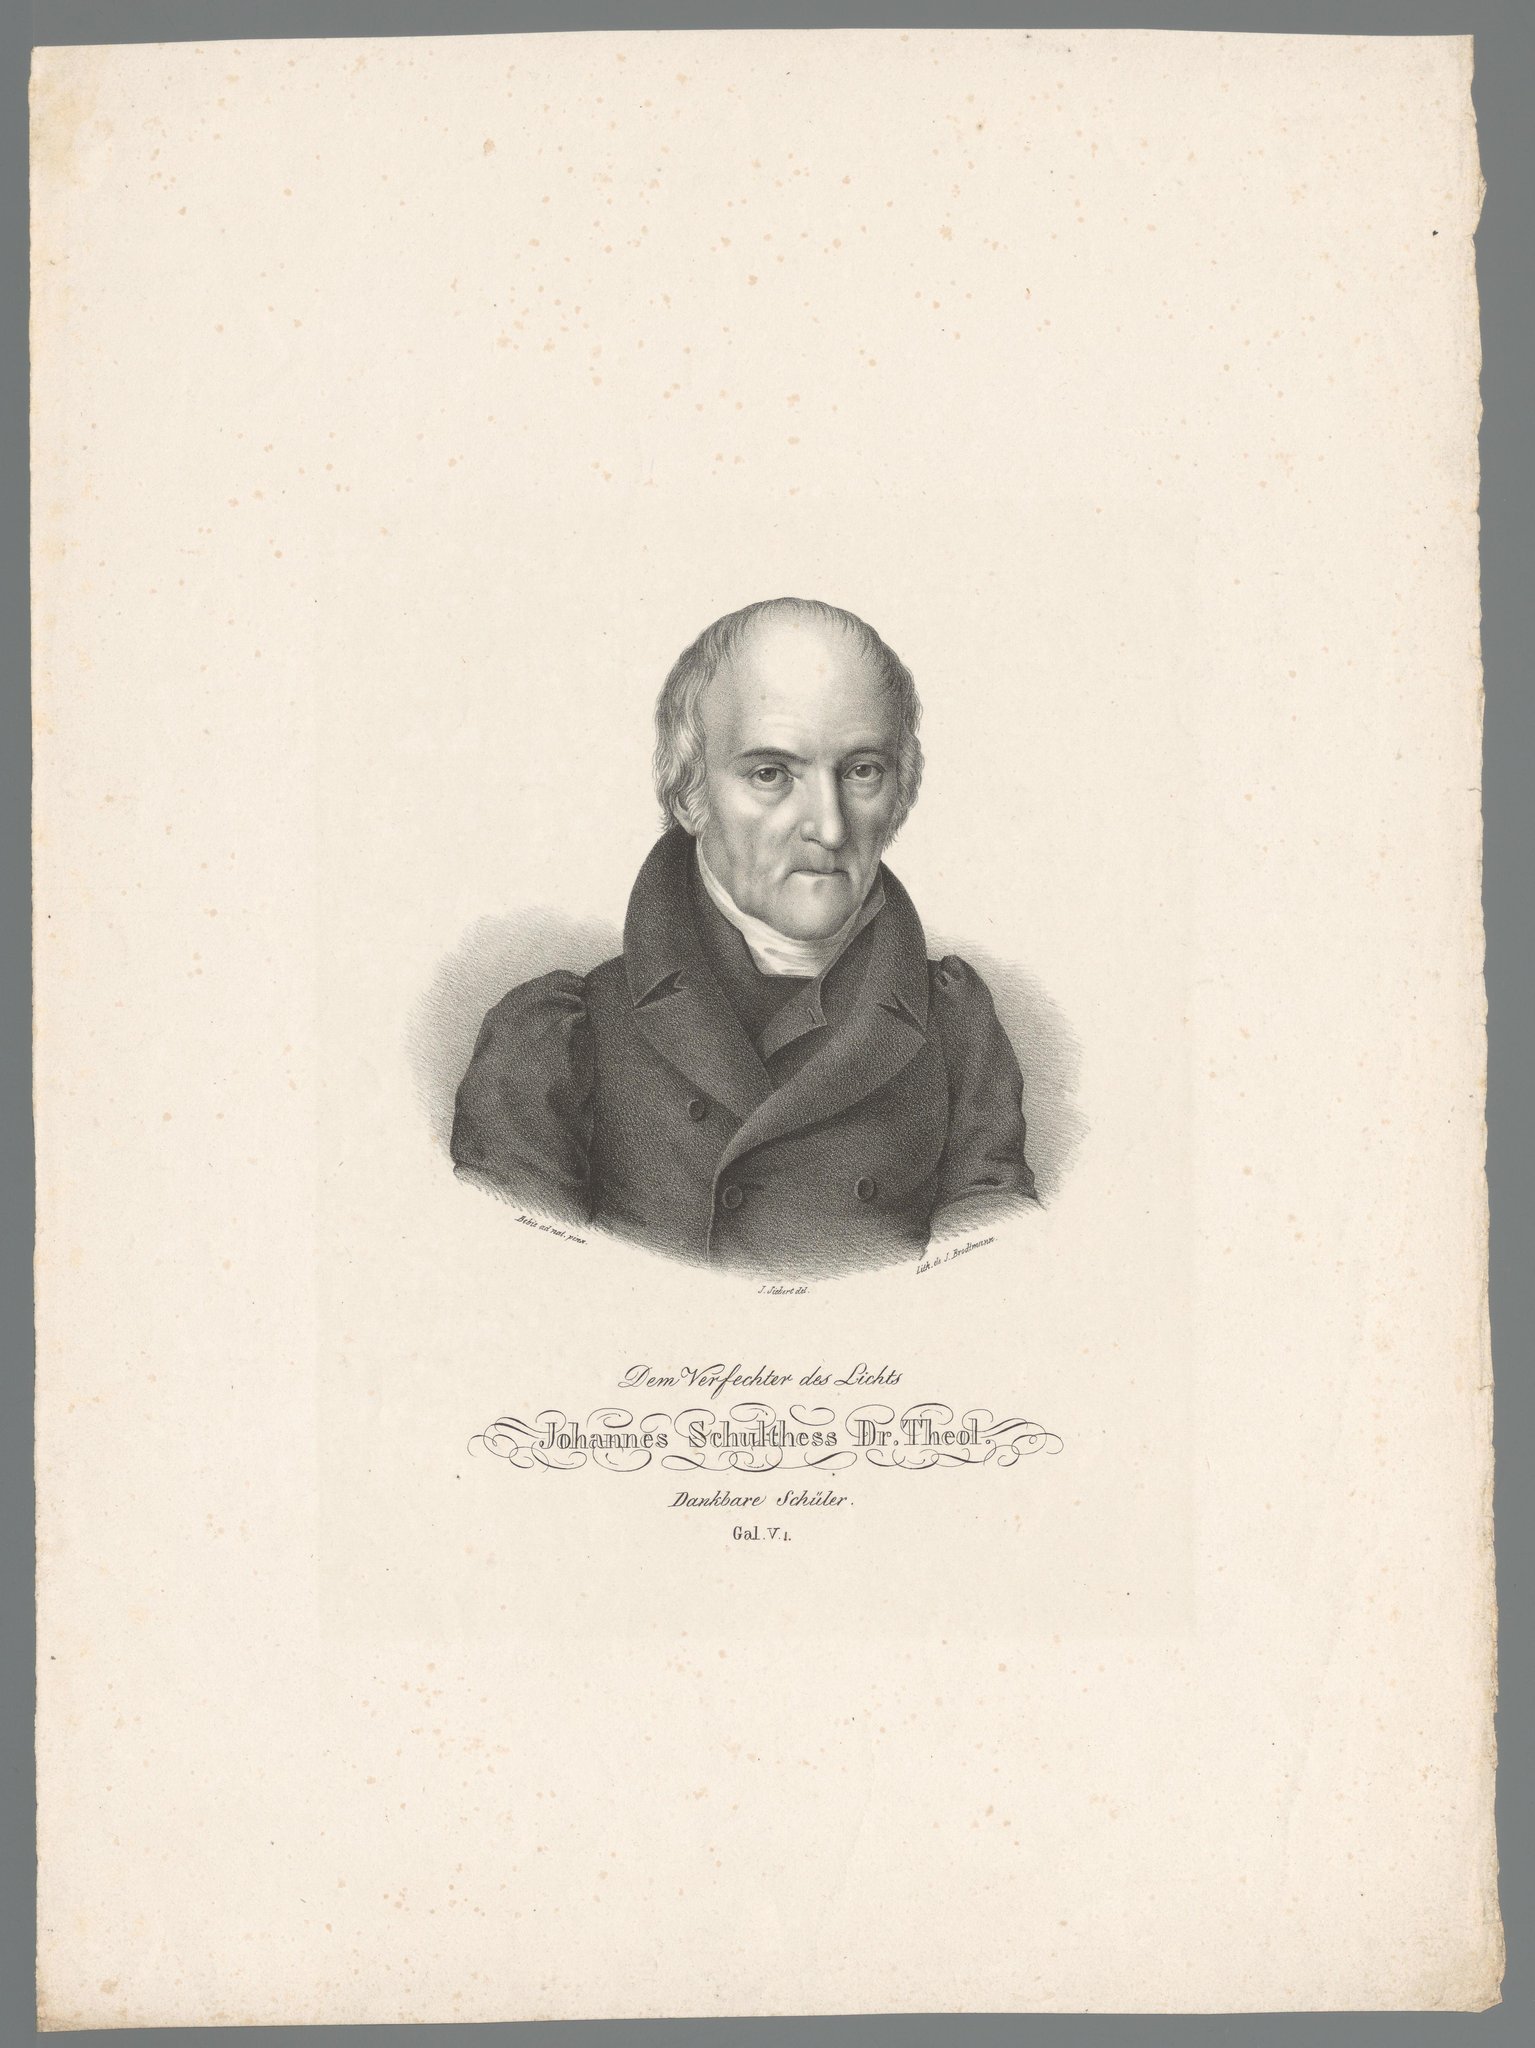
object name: print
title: Dem Verfechter des Lichts, Johannes Schulthess Dr. Theol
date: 1820-1875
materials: paper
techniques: lithograph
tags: adult man, historical persons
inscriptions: collector's mark: Lugt 2228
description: Midden onder: Dankbare Schüler, Gal. V.I.